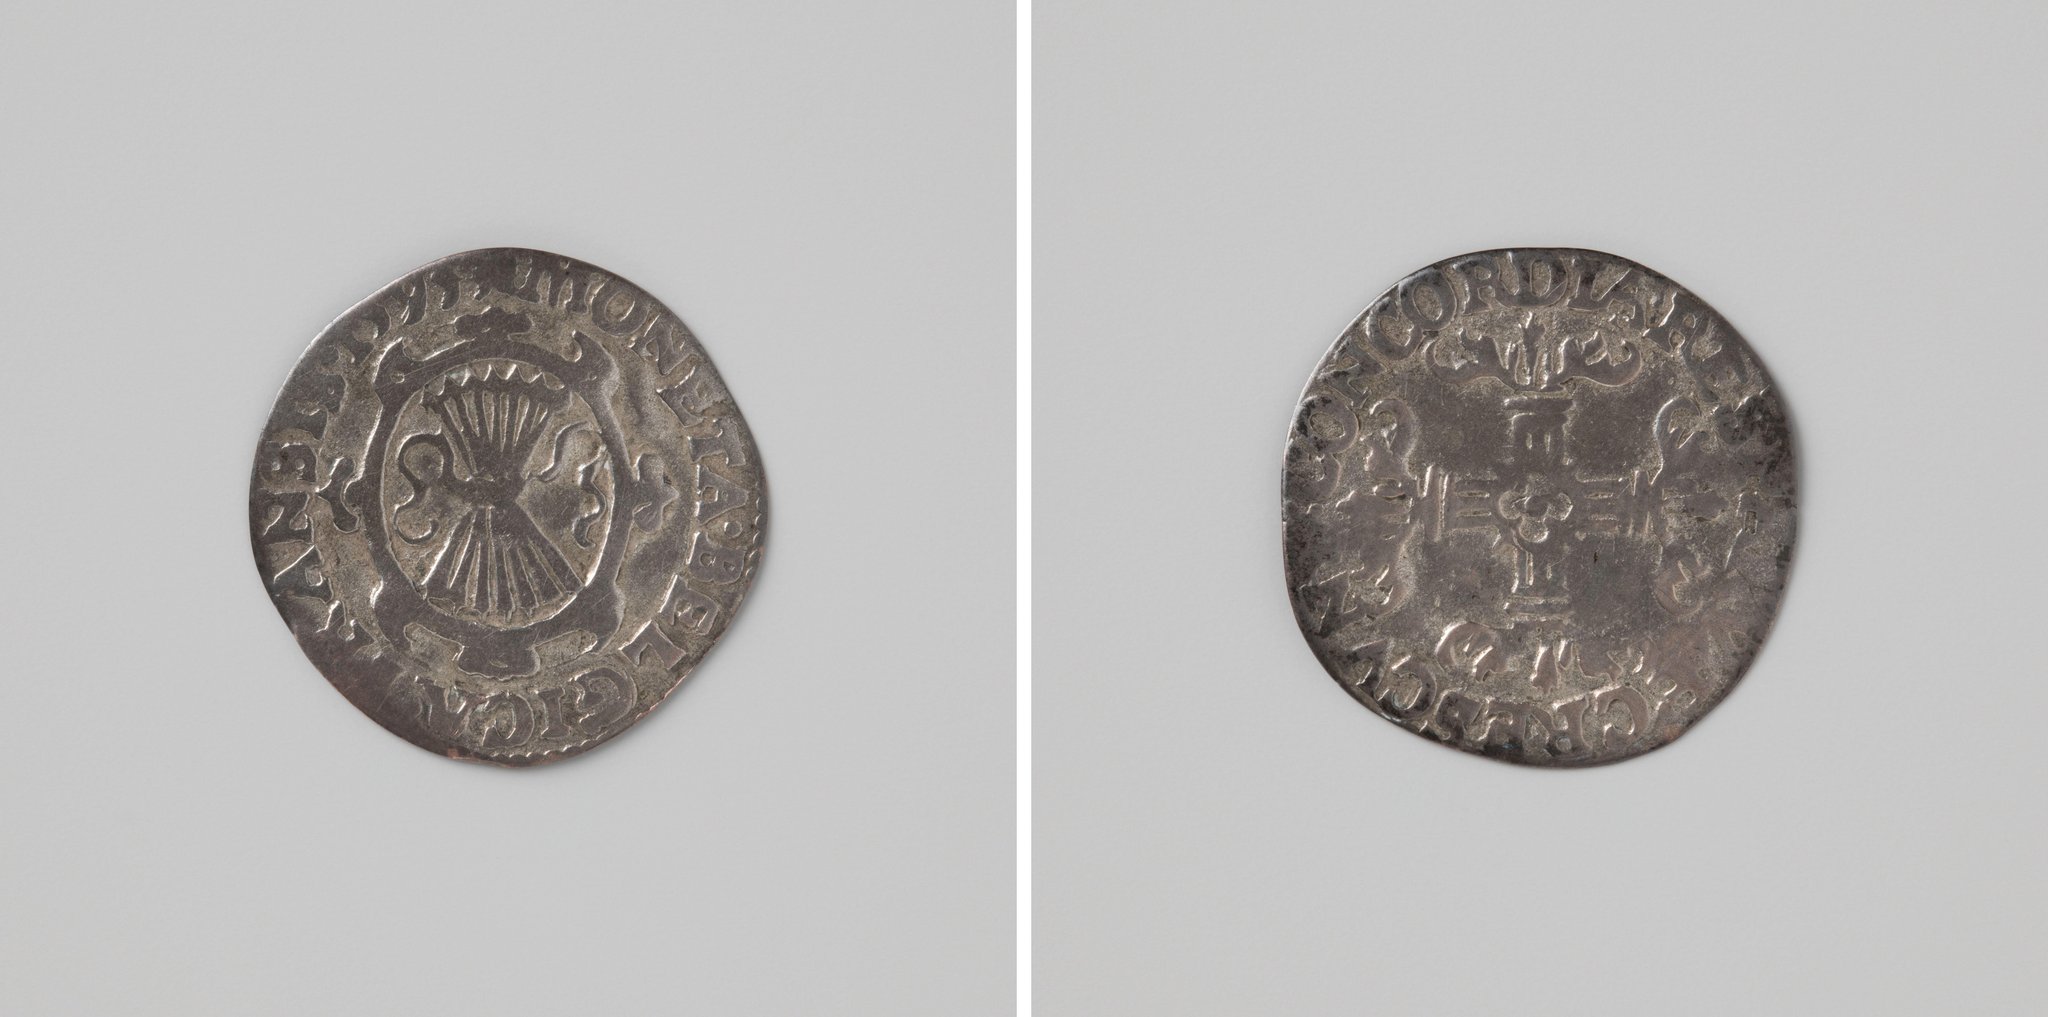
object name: coin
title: Munt van een halve stoter van provincie Overijssel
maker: Anonymous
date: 1593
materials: silver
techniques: striking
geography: overijssel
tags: overijssel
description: Voorzijde: bundel van zeven pijlen in cartouche binnen omschrift. Keerzijde: kruis binnen omschrift